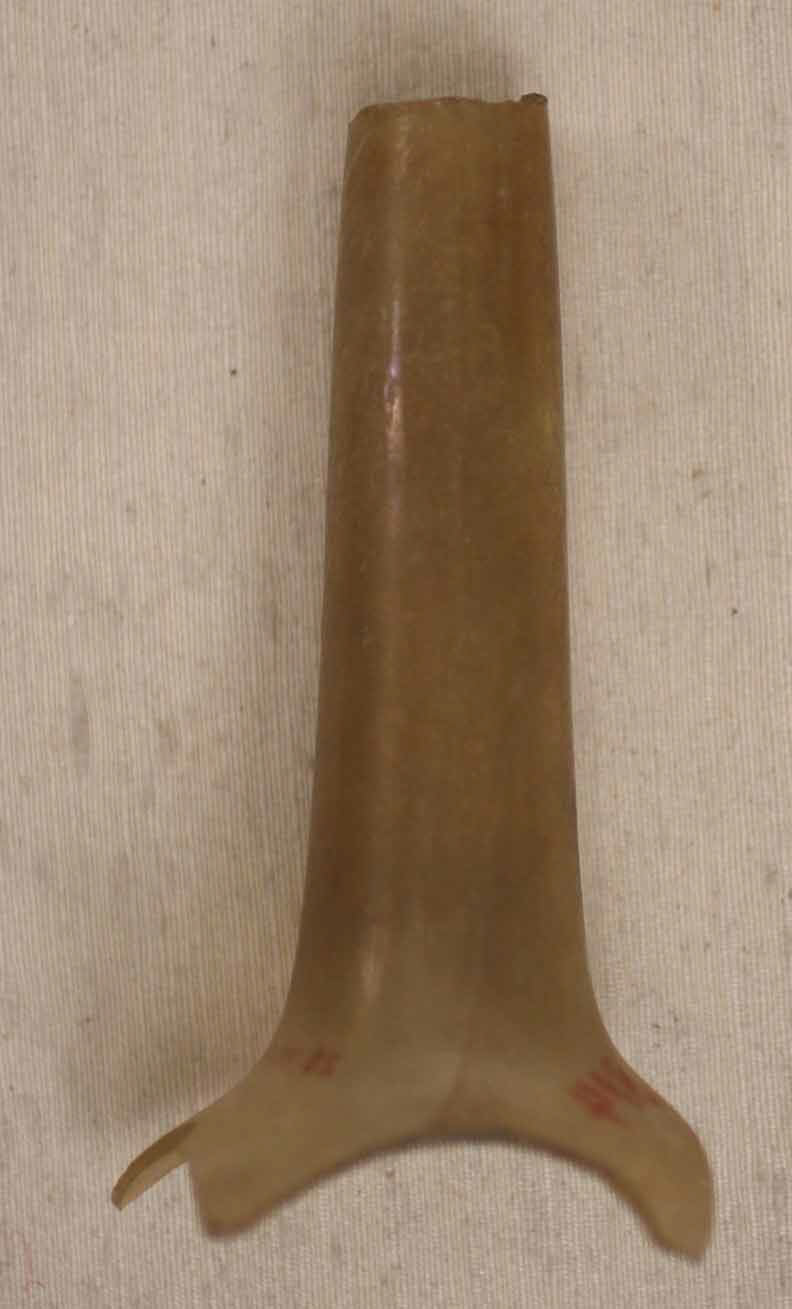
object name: fragment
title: Fragment of Bottle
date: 801-900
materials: glass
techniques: glassblowing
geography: iraq